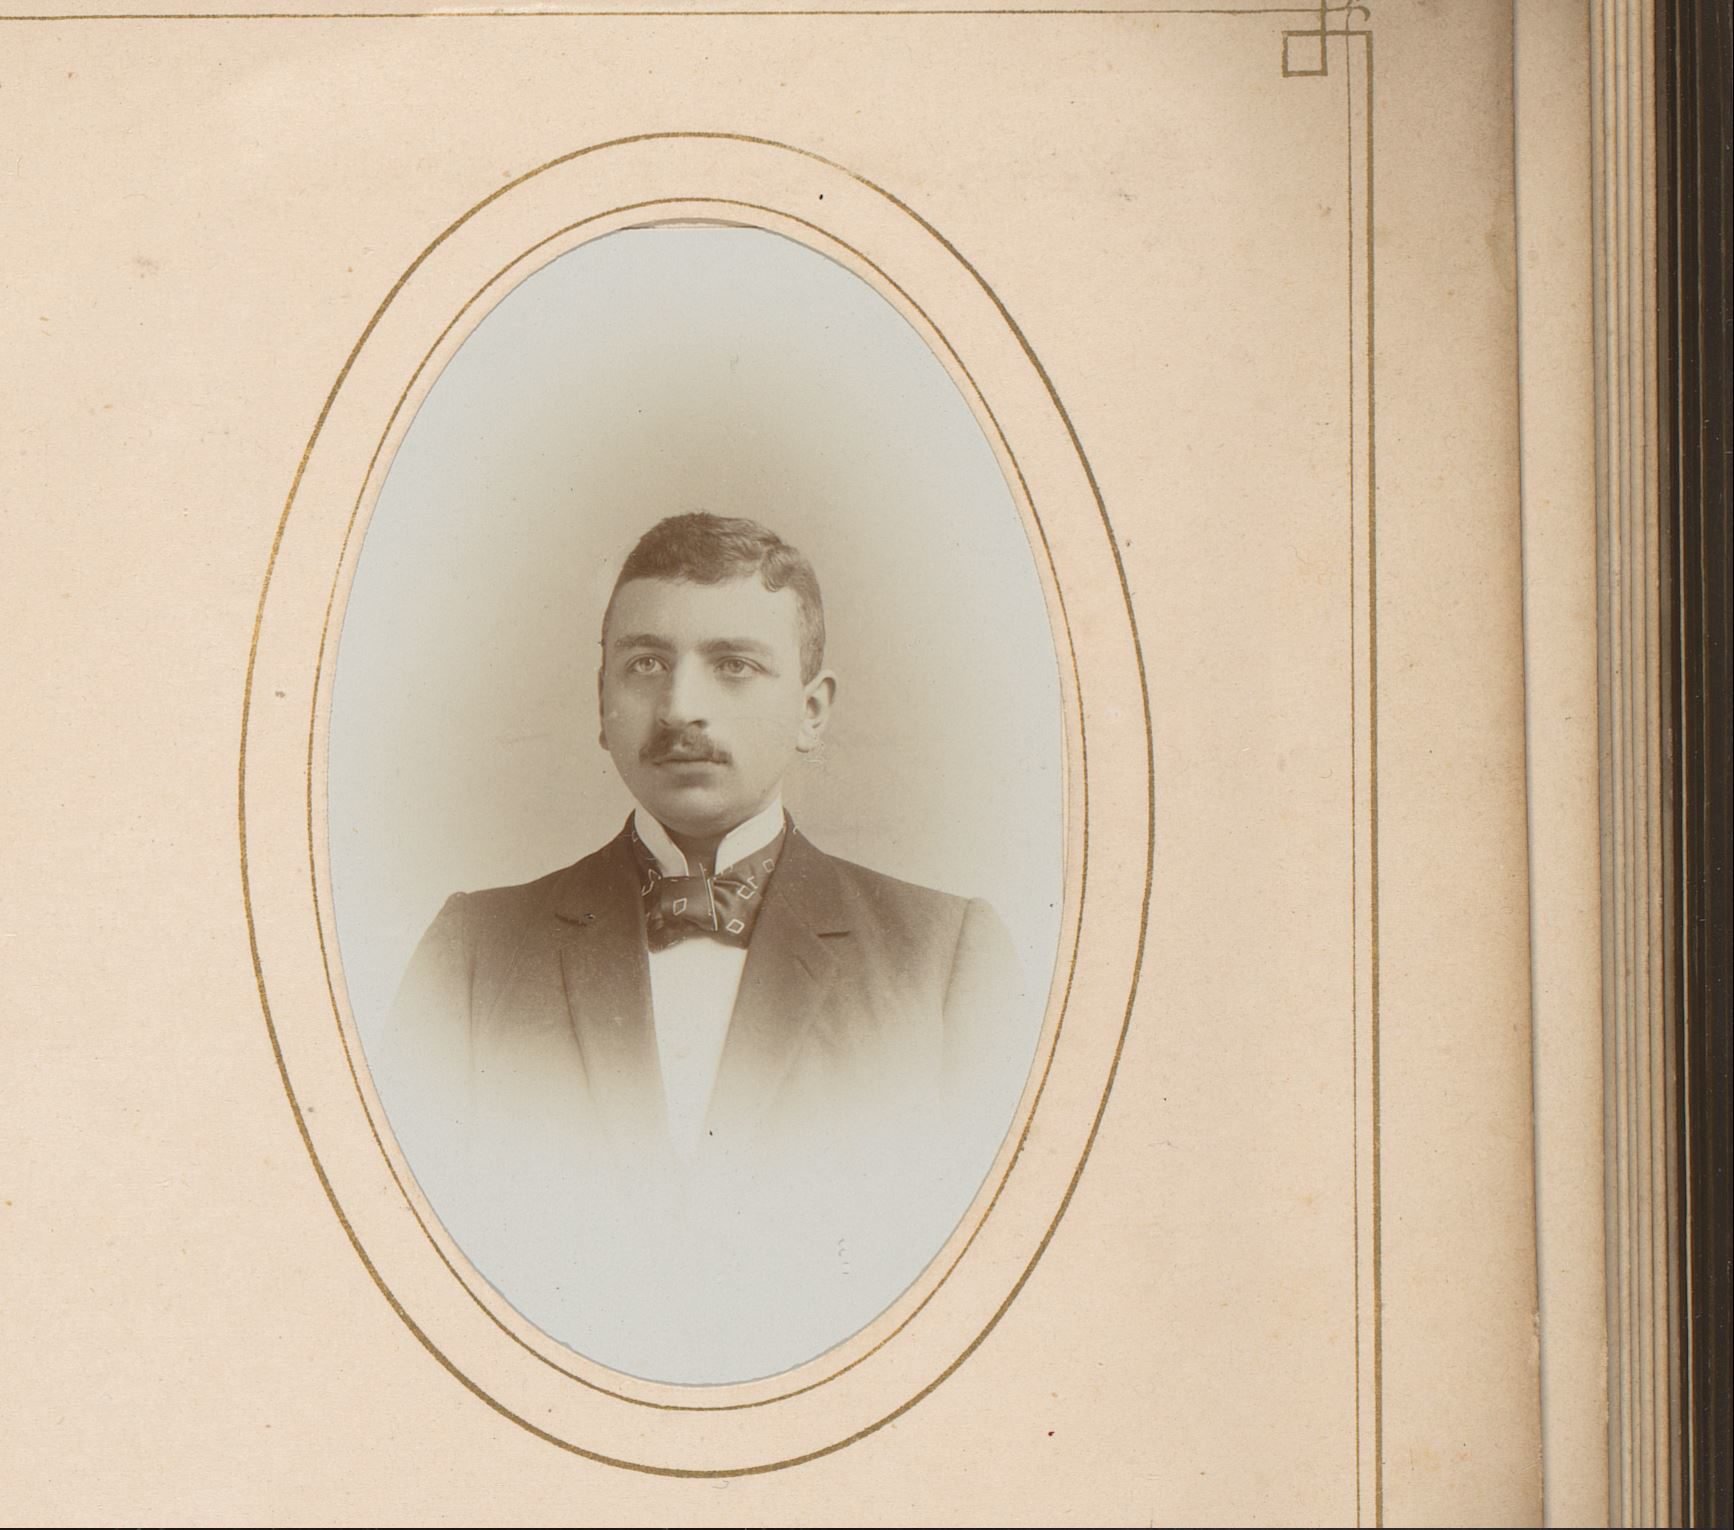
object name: album leaf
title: Portret van een man met snor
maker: aaltje de jong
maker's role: fotograaf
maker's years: 1864-1936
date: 1895-1920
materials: cardboard, photographic support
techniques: collodion silver print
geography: friesland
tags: moustache, youth, adolescent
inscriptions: inscription: ‘Fotogr. Atelier/ de Jong/ Nieuwestad 53/ Leeuwarden/ Heerenveen b/d. Gr. Kerk’